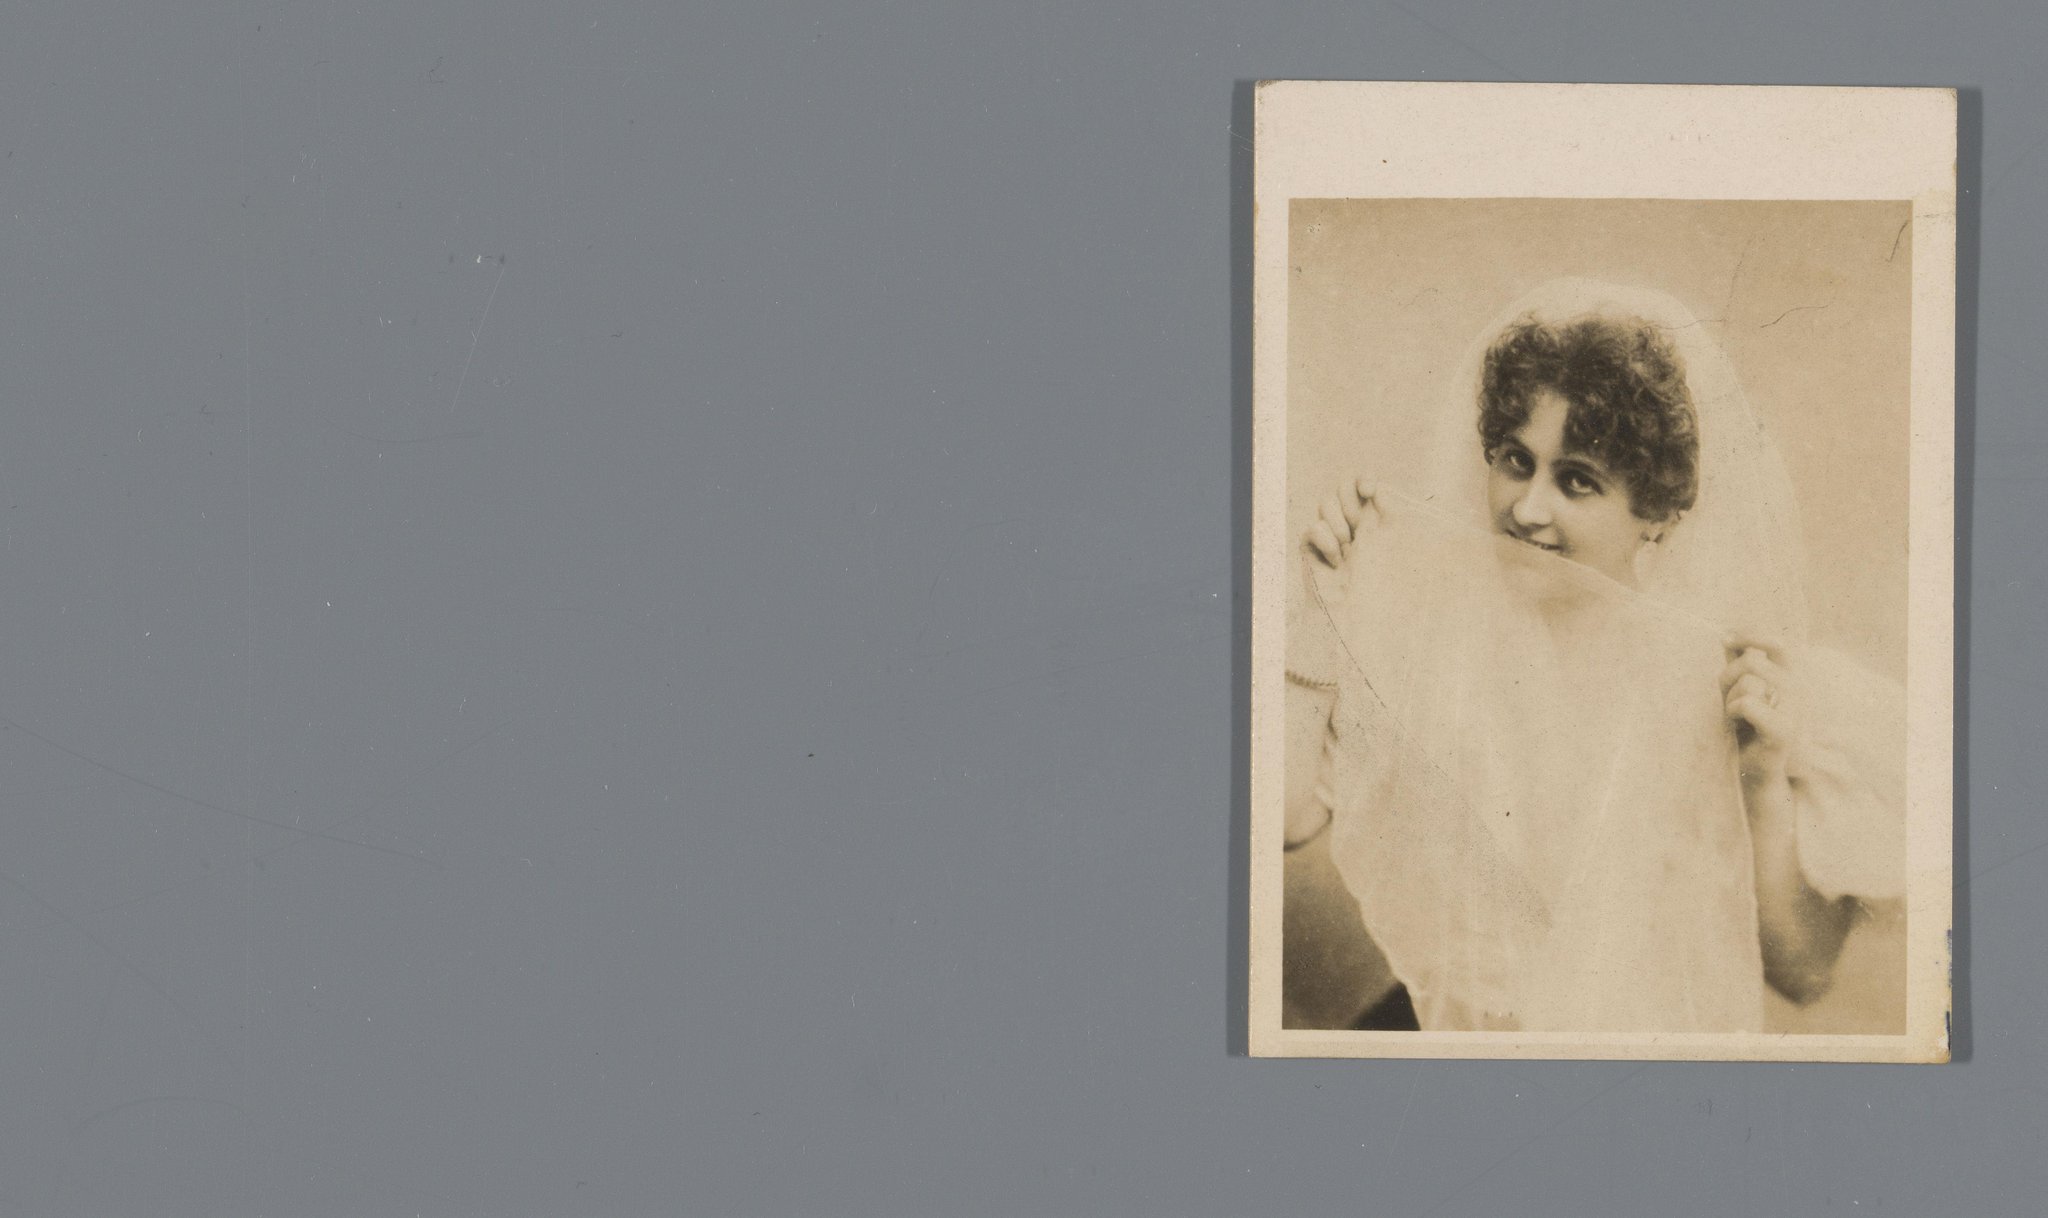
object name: photograph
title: Portret van een onbekende vrouw met sluier, reclame voor Mafiadis et Cie te Constantinopel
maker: Anonymous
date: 1895-1910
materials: photographic support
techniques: gelatin silver print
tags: historical persons - bb - woman, veil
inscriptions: inscription: ‘Cigarettes/ Mafiadis et Cie./ à Constantinople.’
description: Dergelijke foto's stonden bekend als 'zwartjes'. Men verkreeg ze bij aanschaf van bepaalde merken thee, cacao, sigaretten, beschuit, etc. om te verzamelen. Er waren speciaal voor de 'zwartjes' verzamelalbums in omloop.